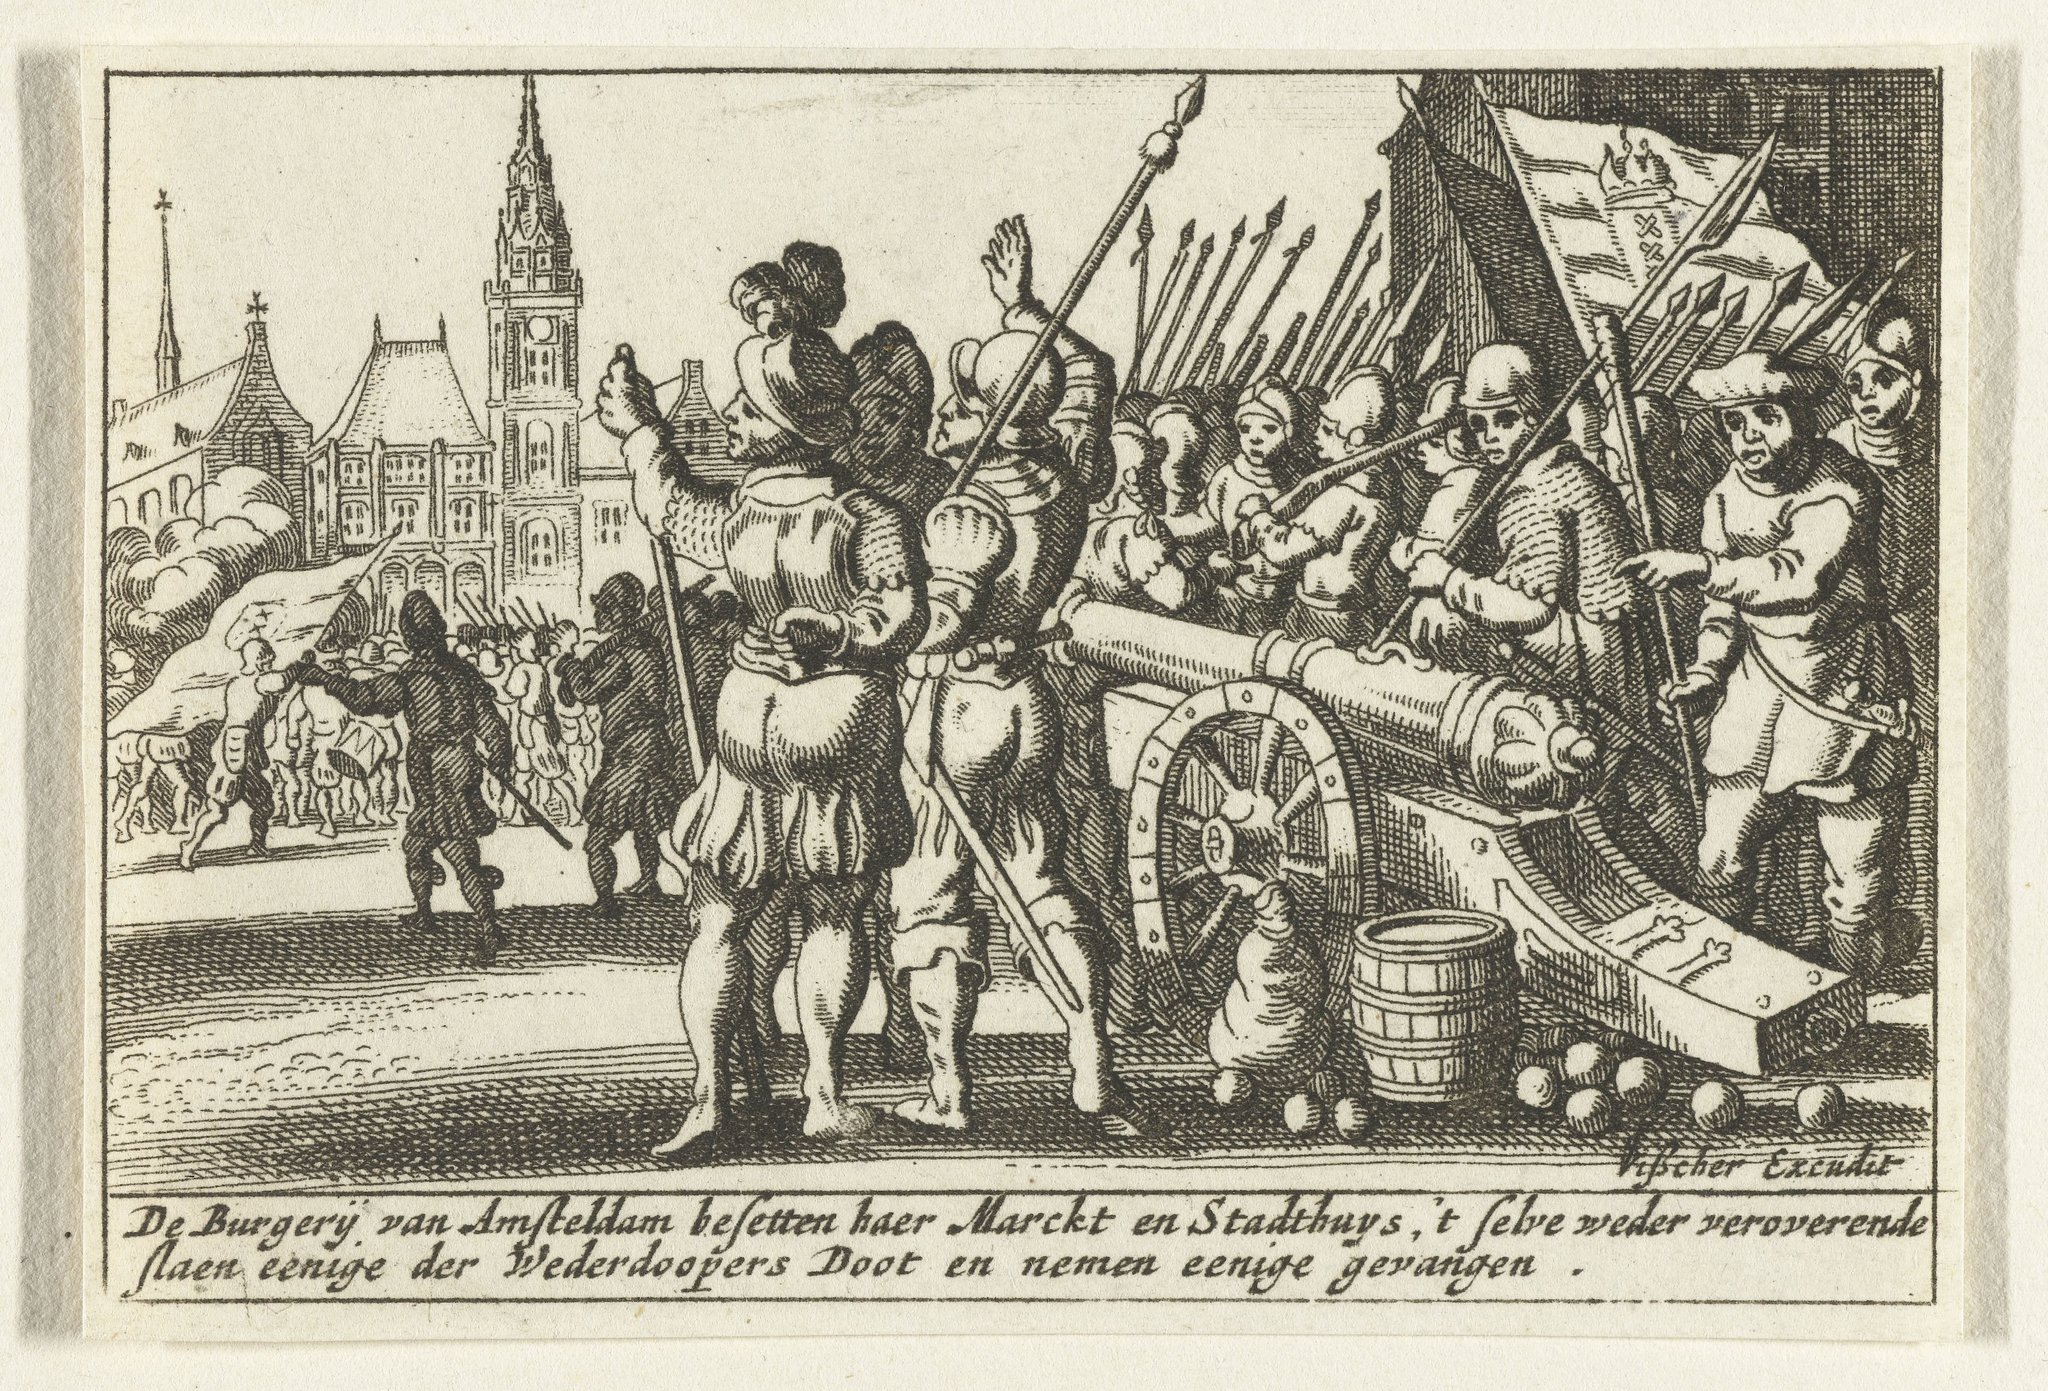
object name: history print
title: Opstand van de wederdopers te Amsterdam in 1534-1535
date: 1629-1652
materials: paper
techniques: etching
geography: northern netherlands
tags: amsterdam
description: Deze prenten zijn gebaseerd op de oorspronkelijke anonieme gravures in de eerste uitgave L. Hortensius, Van den oproer der weder-dooperen, 1614. Alle 8 prenten op op één blad geplakt. Naar het verloren gegane schilderij van Barend Dircksz. in het oude stadhuis te Amsterdam.